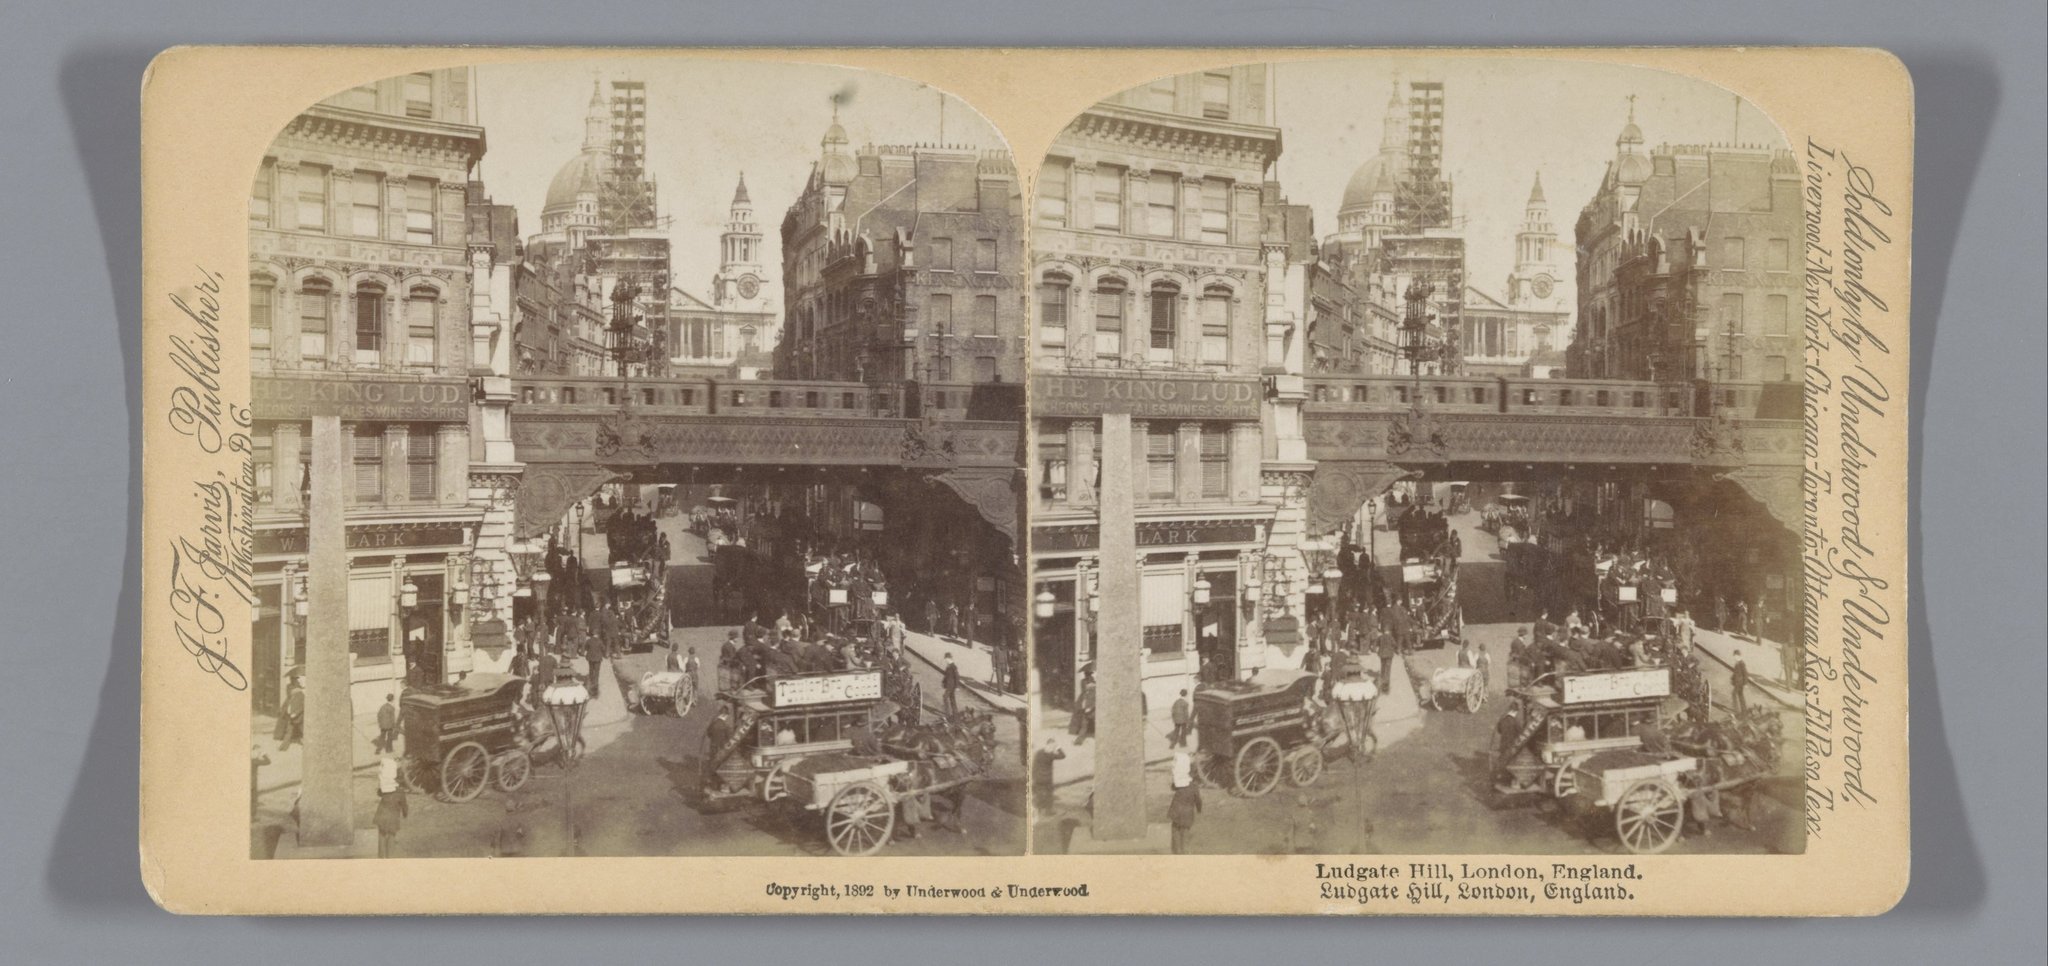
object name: stereograph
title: Ludgate Hill, London, England.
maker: john fillis jarvis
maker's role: publisher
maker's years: 1849-1931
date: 1892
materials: cardboard, photographic support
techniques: albumen print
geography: washington d.c.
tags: covered wagon, hooded wagon, façade (of house or building), street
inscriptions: name: ‘Sold only by Underwood & Underwood Liverpool-New York-Chicago-Toronto-Ottawa Kas-El Paso Tex.’